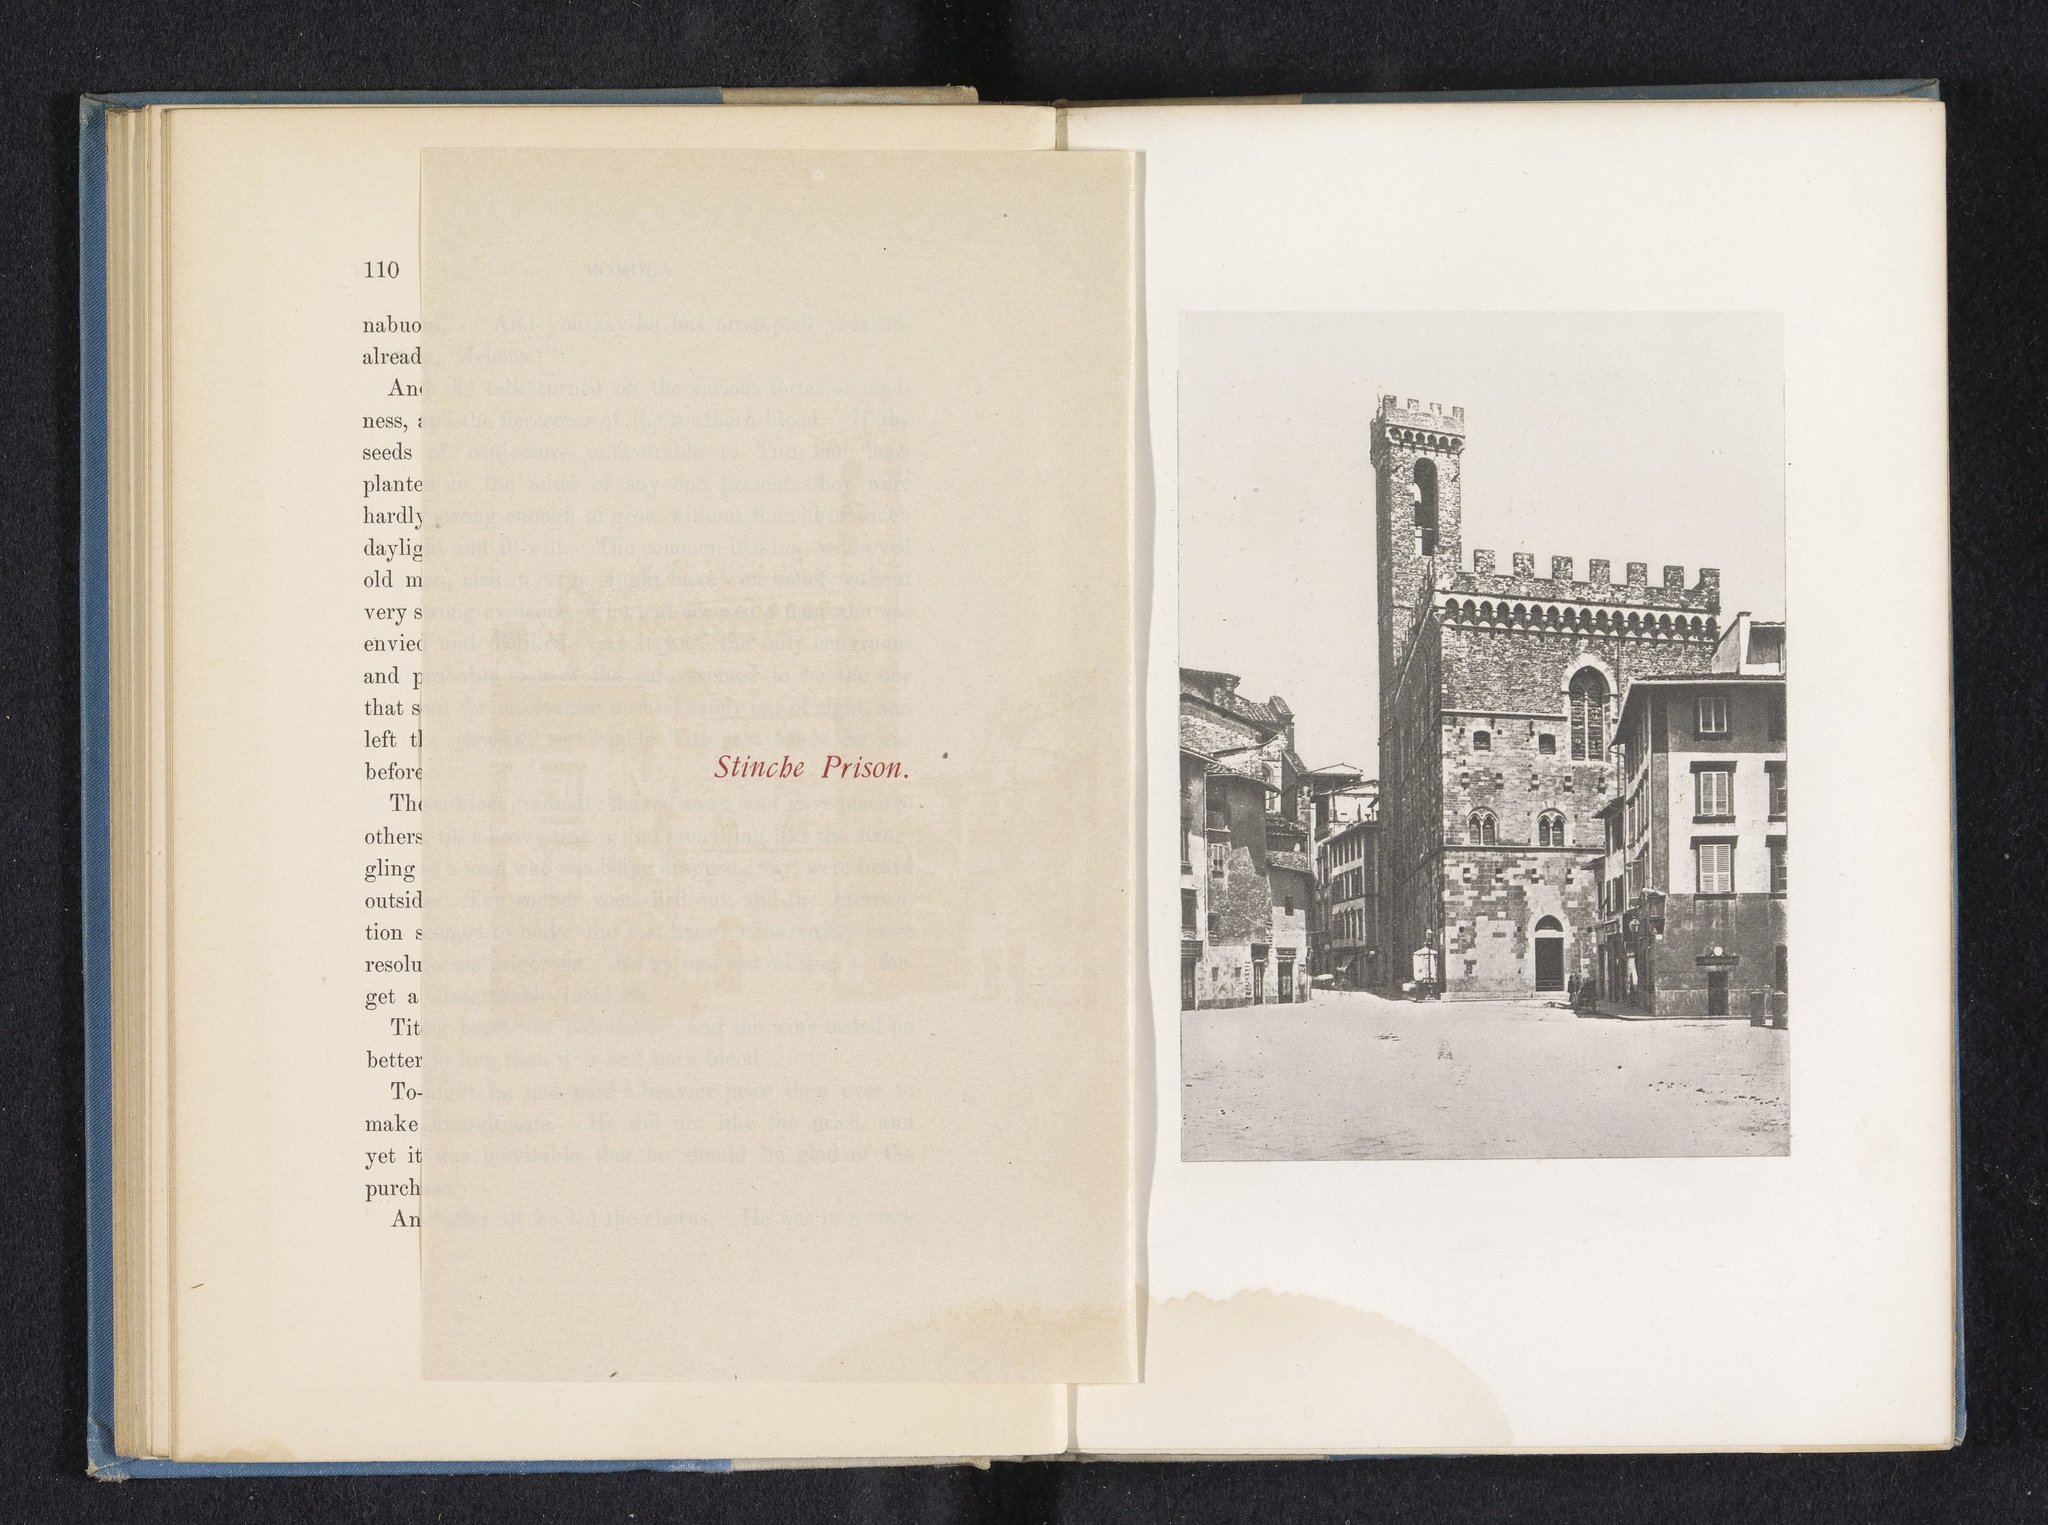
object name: page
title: Exterieur van de gevangenis Le Stinche te Florence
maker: Anonymous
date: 1880-1890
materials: paper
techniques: photoaquatint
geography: boston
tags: prison, jail, façade (of house or building)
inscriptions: title: ‘Stinche Prison.’